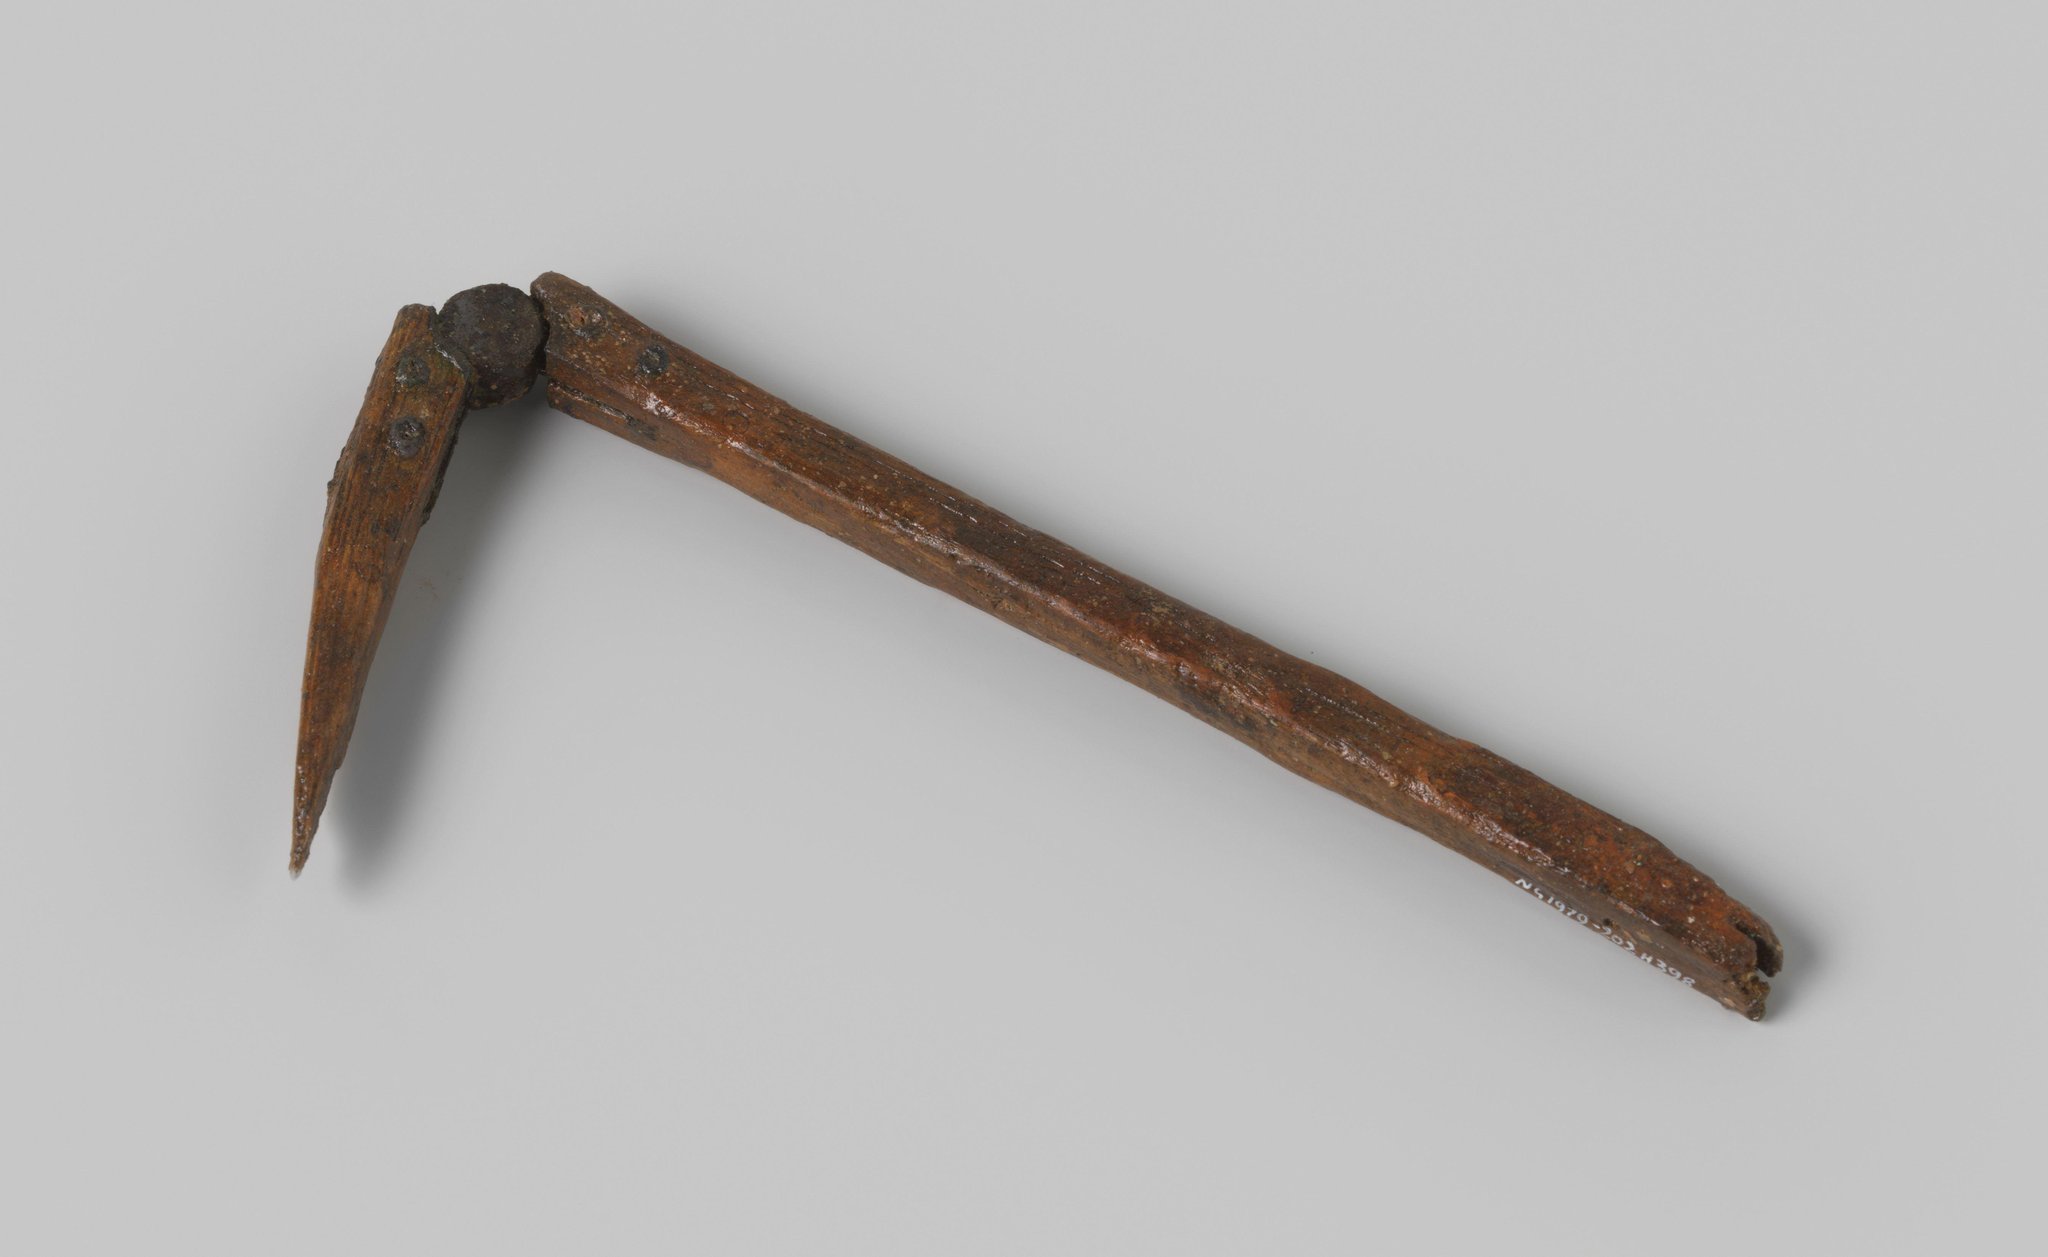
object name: folding rule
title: Duimstok uit het wrak van de Oost-Indiëvaarder Hollandia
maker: Anonymous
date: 1700-1743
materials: copper, wood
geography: netherlands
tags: verenigde oostindische compagnie, hollandia (schip), annet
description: Folding ruler; eroded: 2 rulers, square in section, engraved scale, ends broken, with circular hinge.